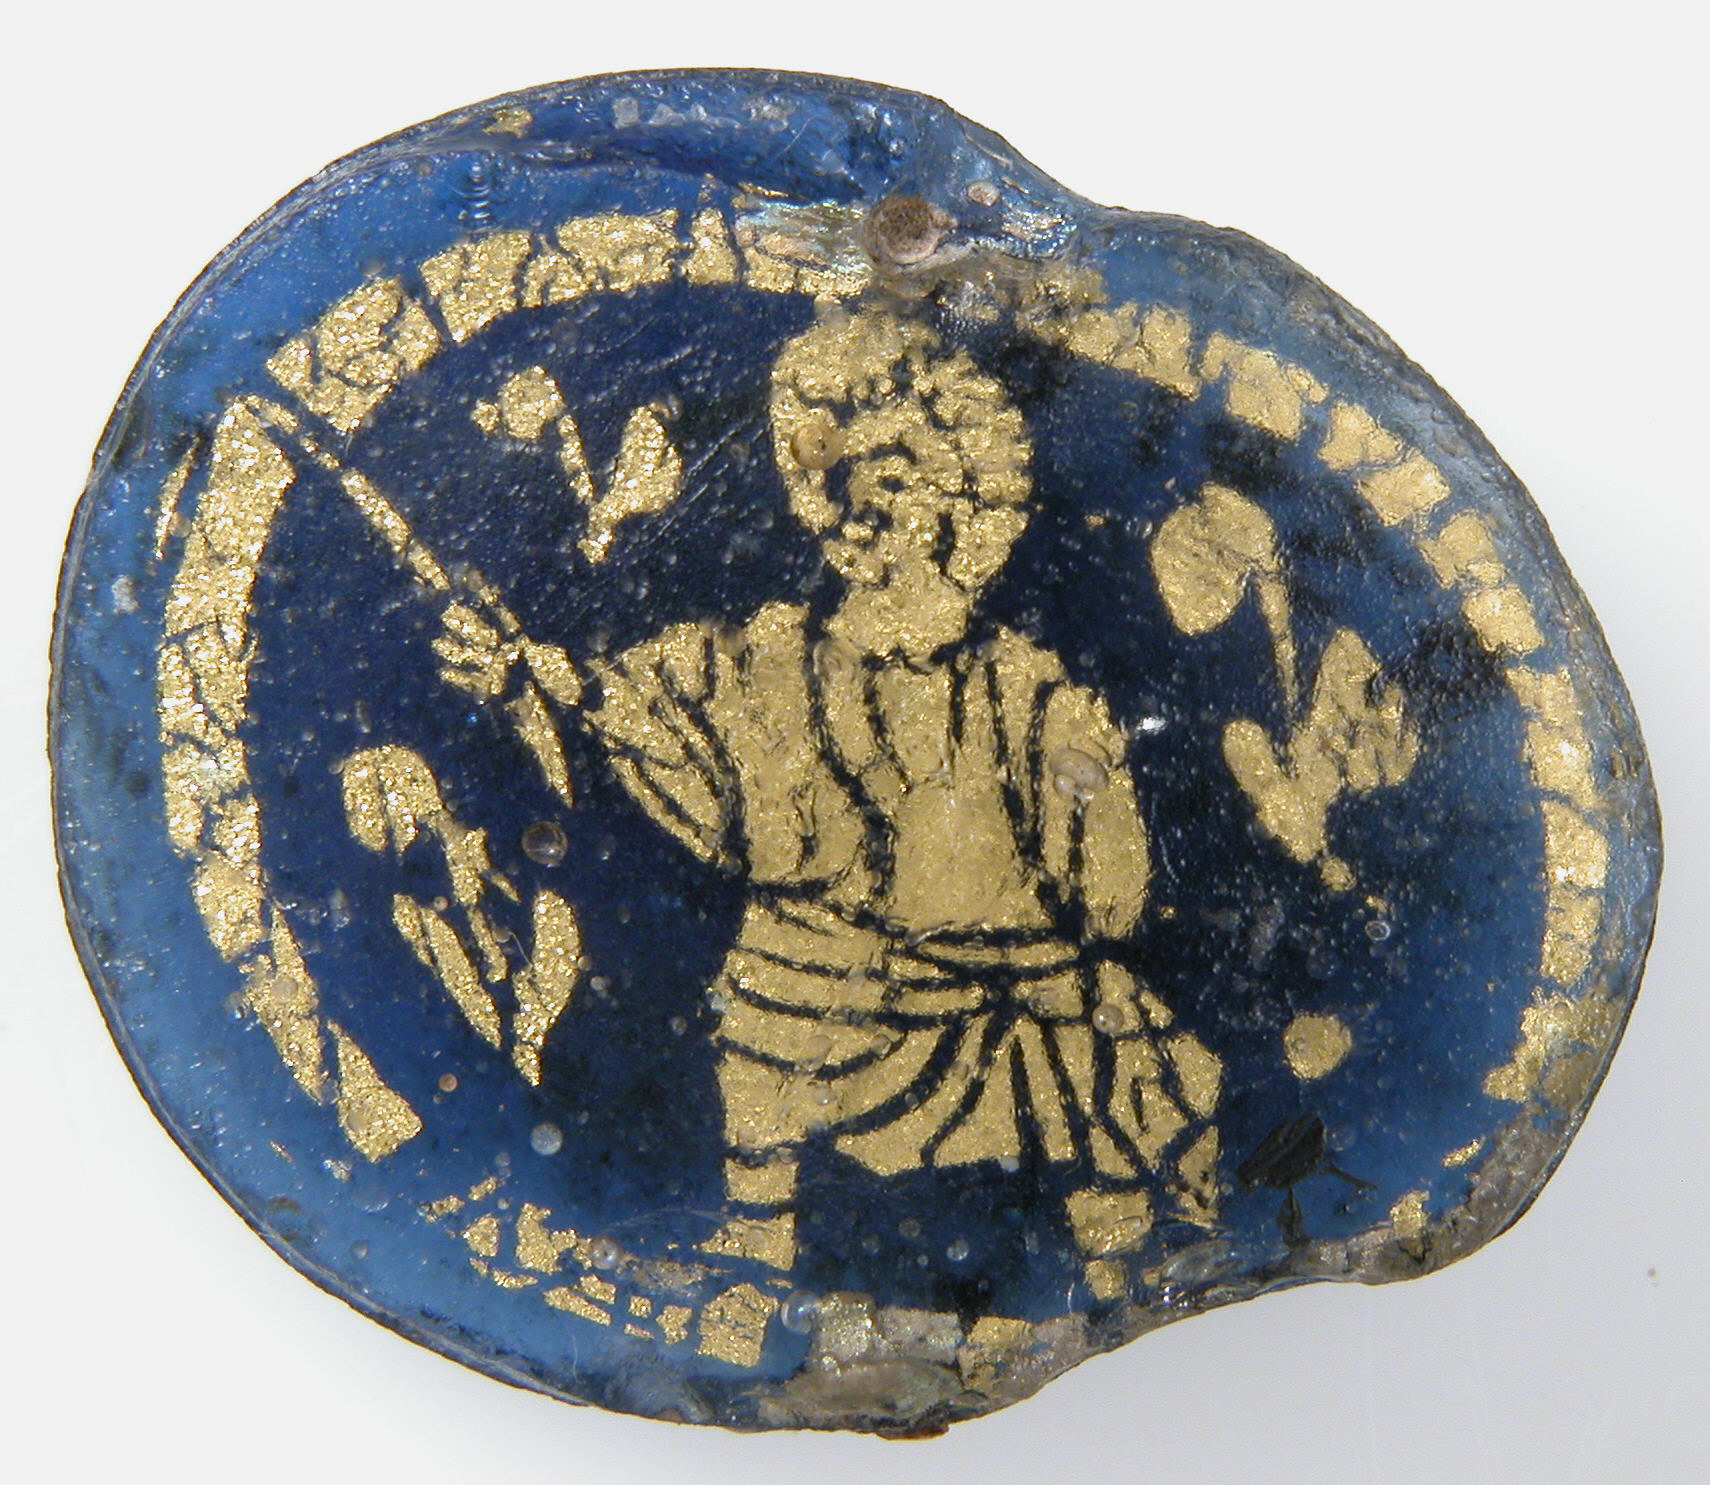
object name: medallion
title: Gold Glass Medallion with Christ as a Miracle Worker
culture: byzantine or roman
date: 300-500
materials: glass, gold leaf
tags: christ